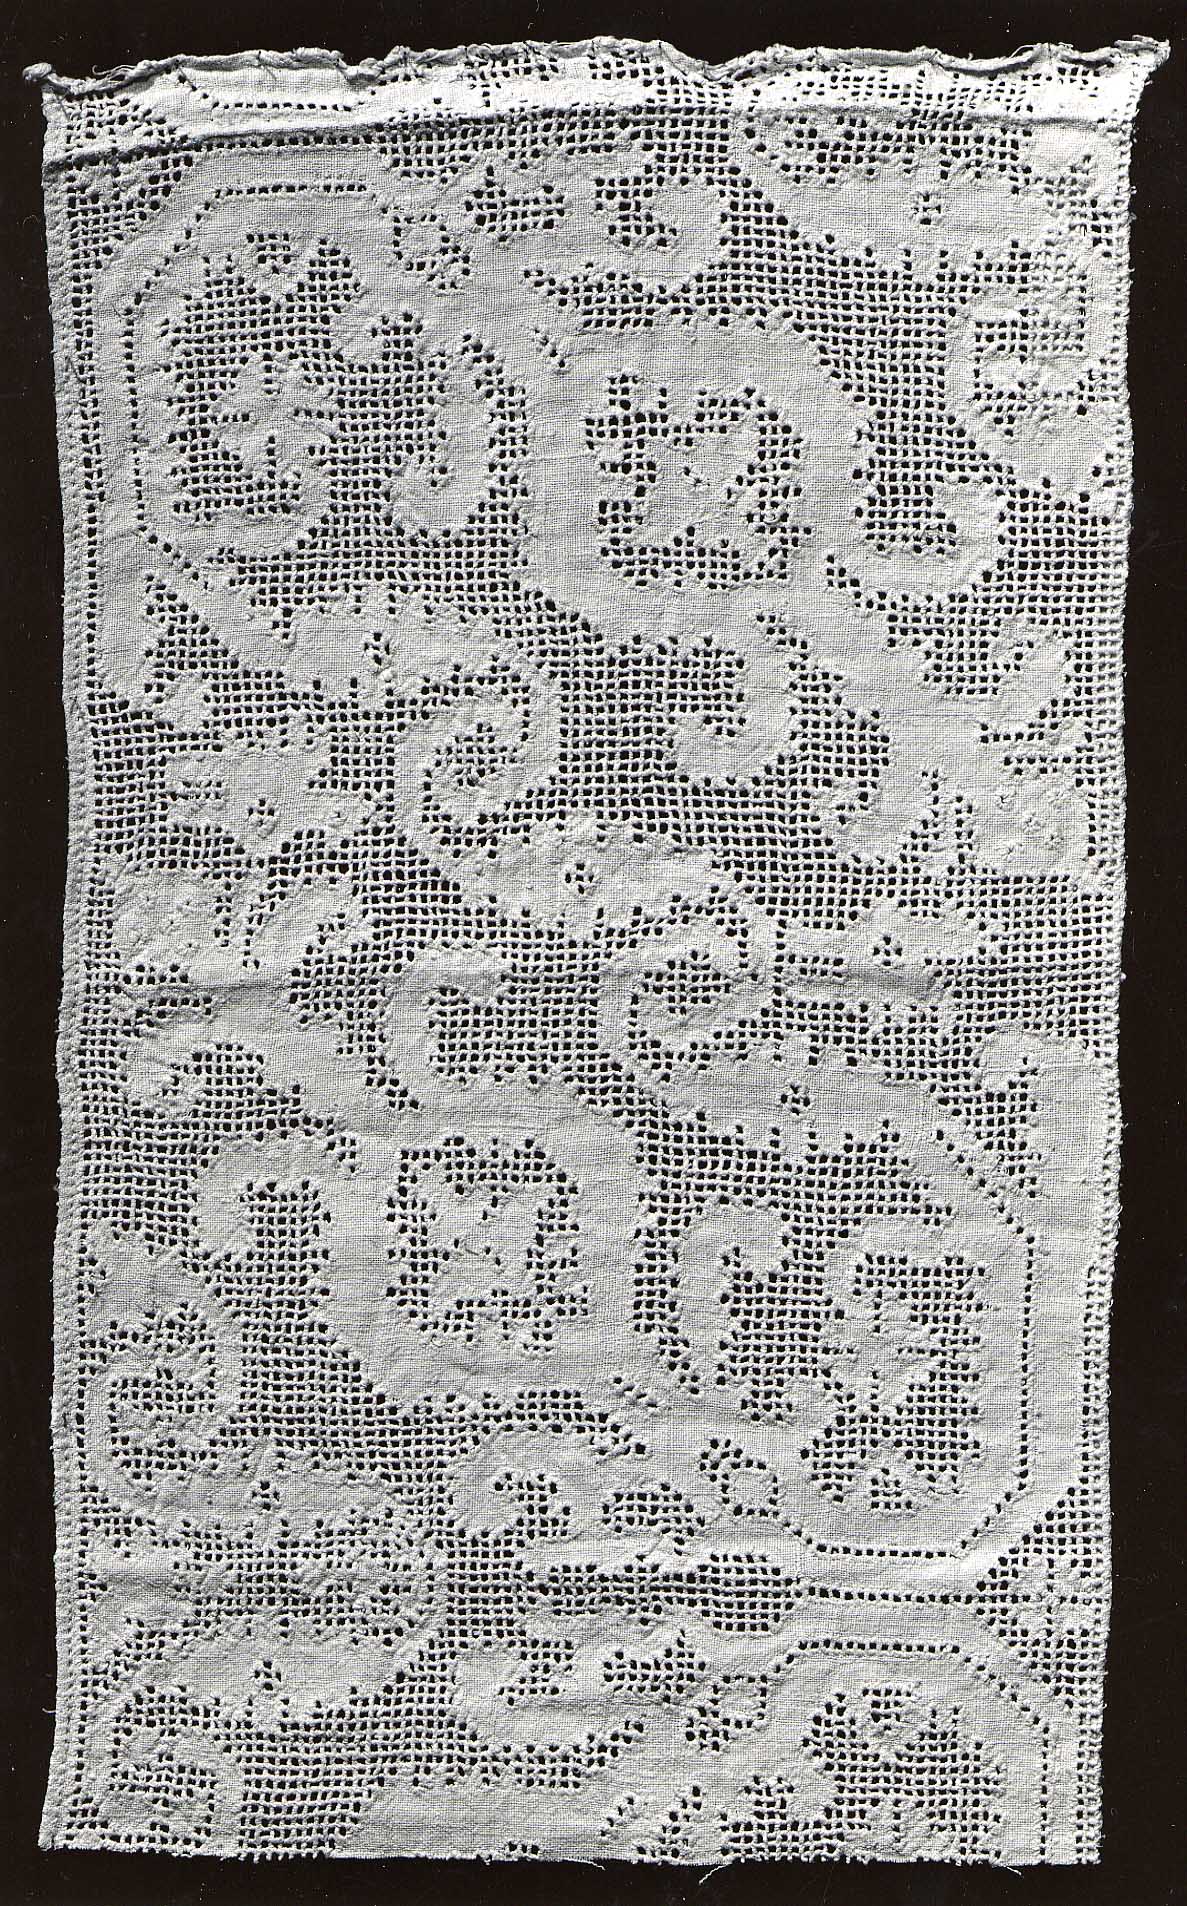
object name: textile border fragment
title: Border Fragment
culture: italian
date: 1601-1700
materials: linen